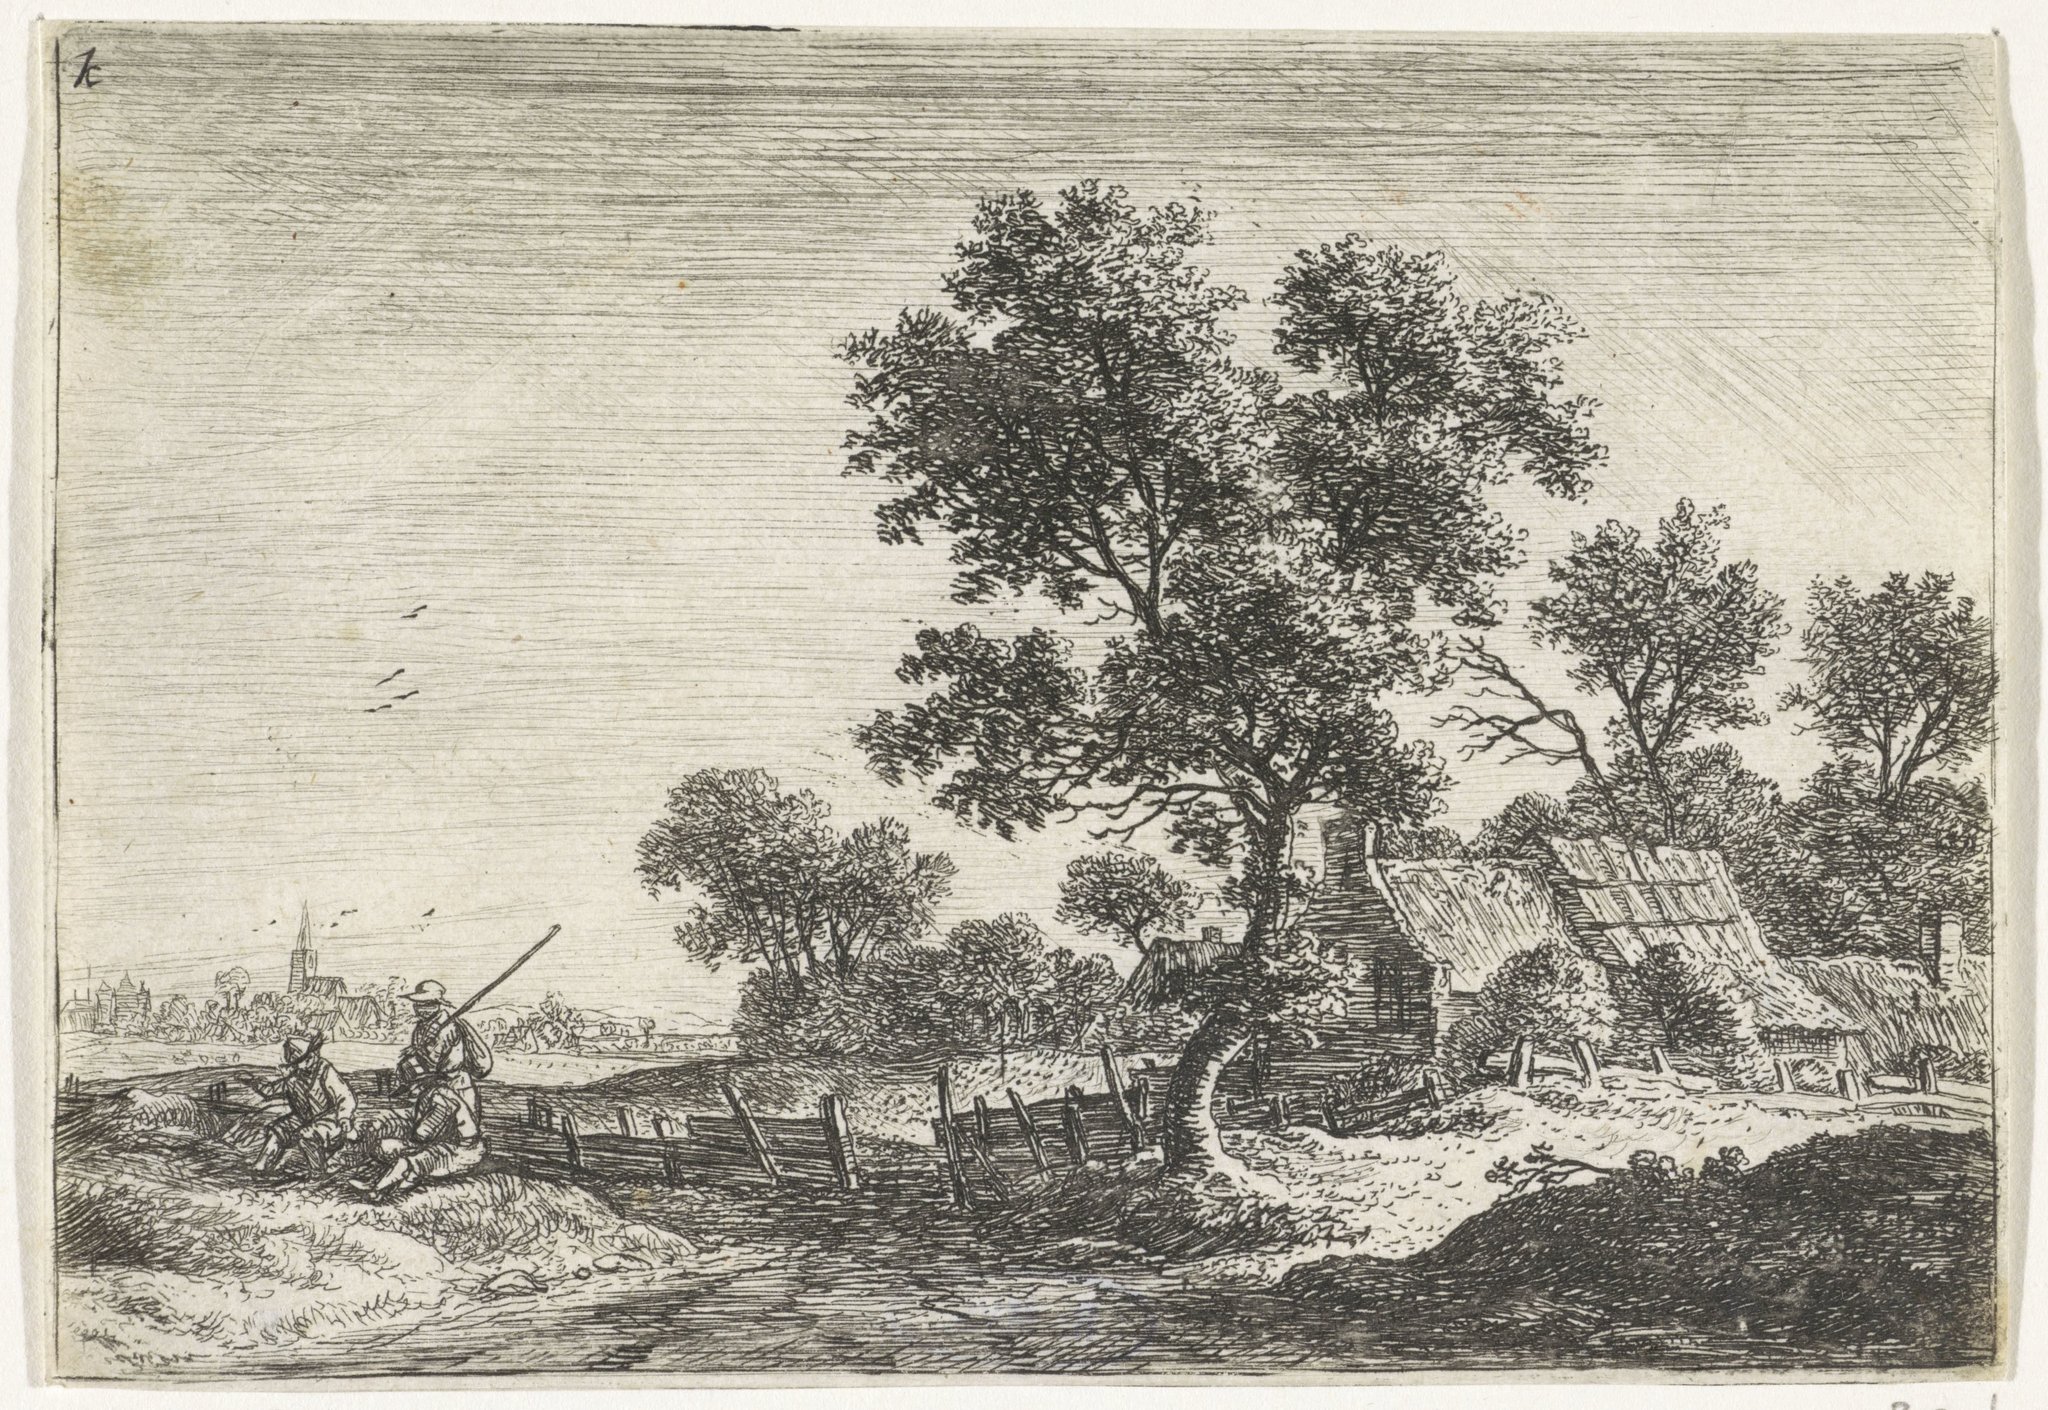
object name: print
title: Landschappen met figuren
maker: anthonie waterloo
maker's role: draughtsman, painter, print maker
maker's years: 1609-1690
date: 1630-1663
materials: paper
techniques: etching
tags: village, church (exterior), landscapes (+ landscape with figures, staffage)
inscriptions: collector's mark: Lugt 2228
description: Links zitten twee boeren op een heuvel voor een hek. Rechts ligt een dorp tussen de bomen. In de verte is een kerk weergegeven. Linksboven is de letter k te zien.